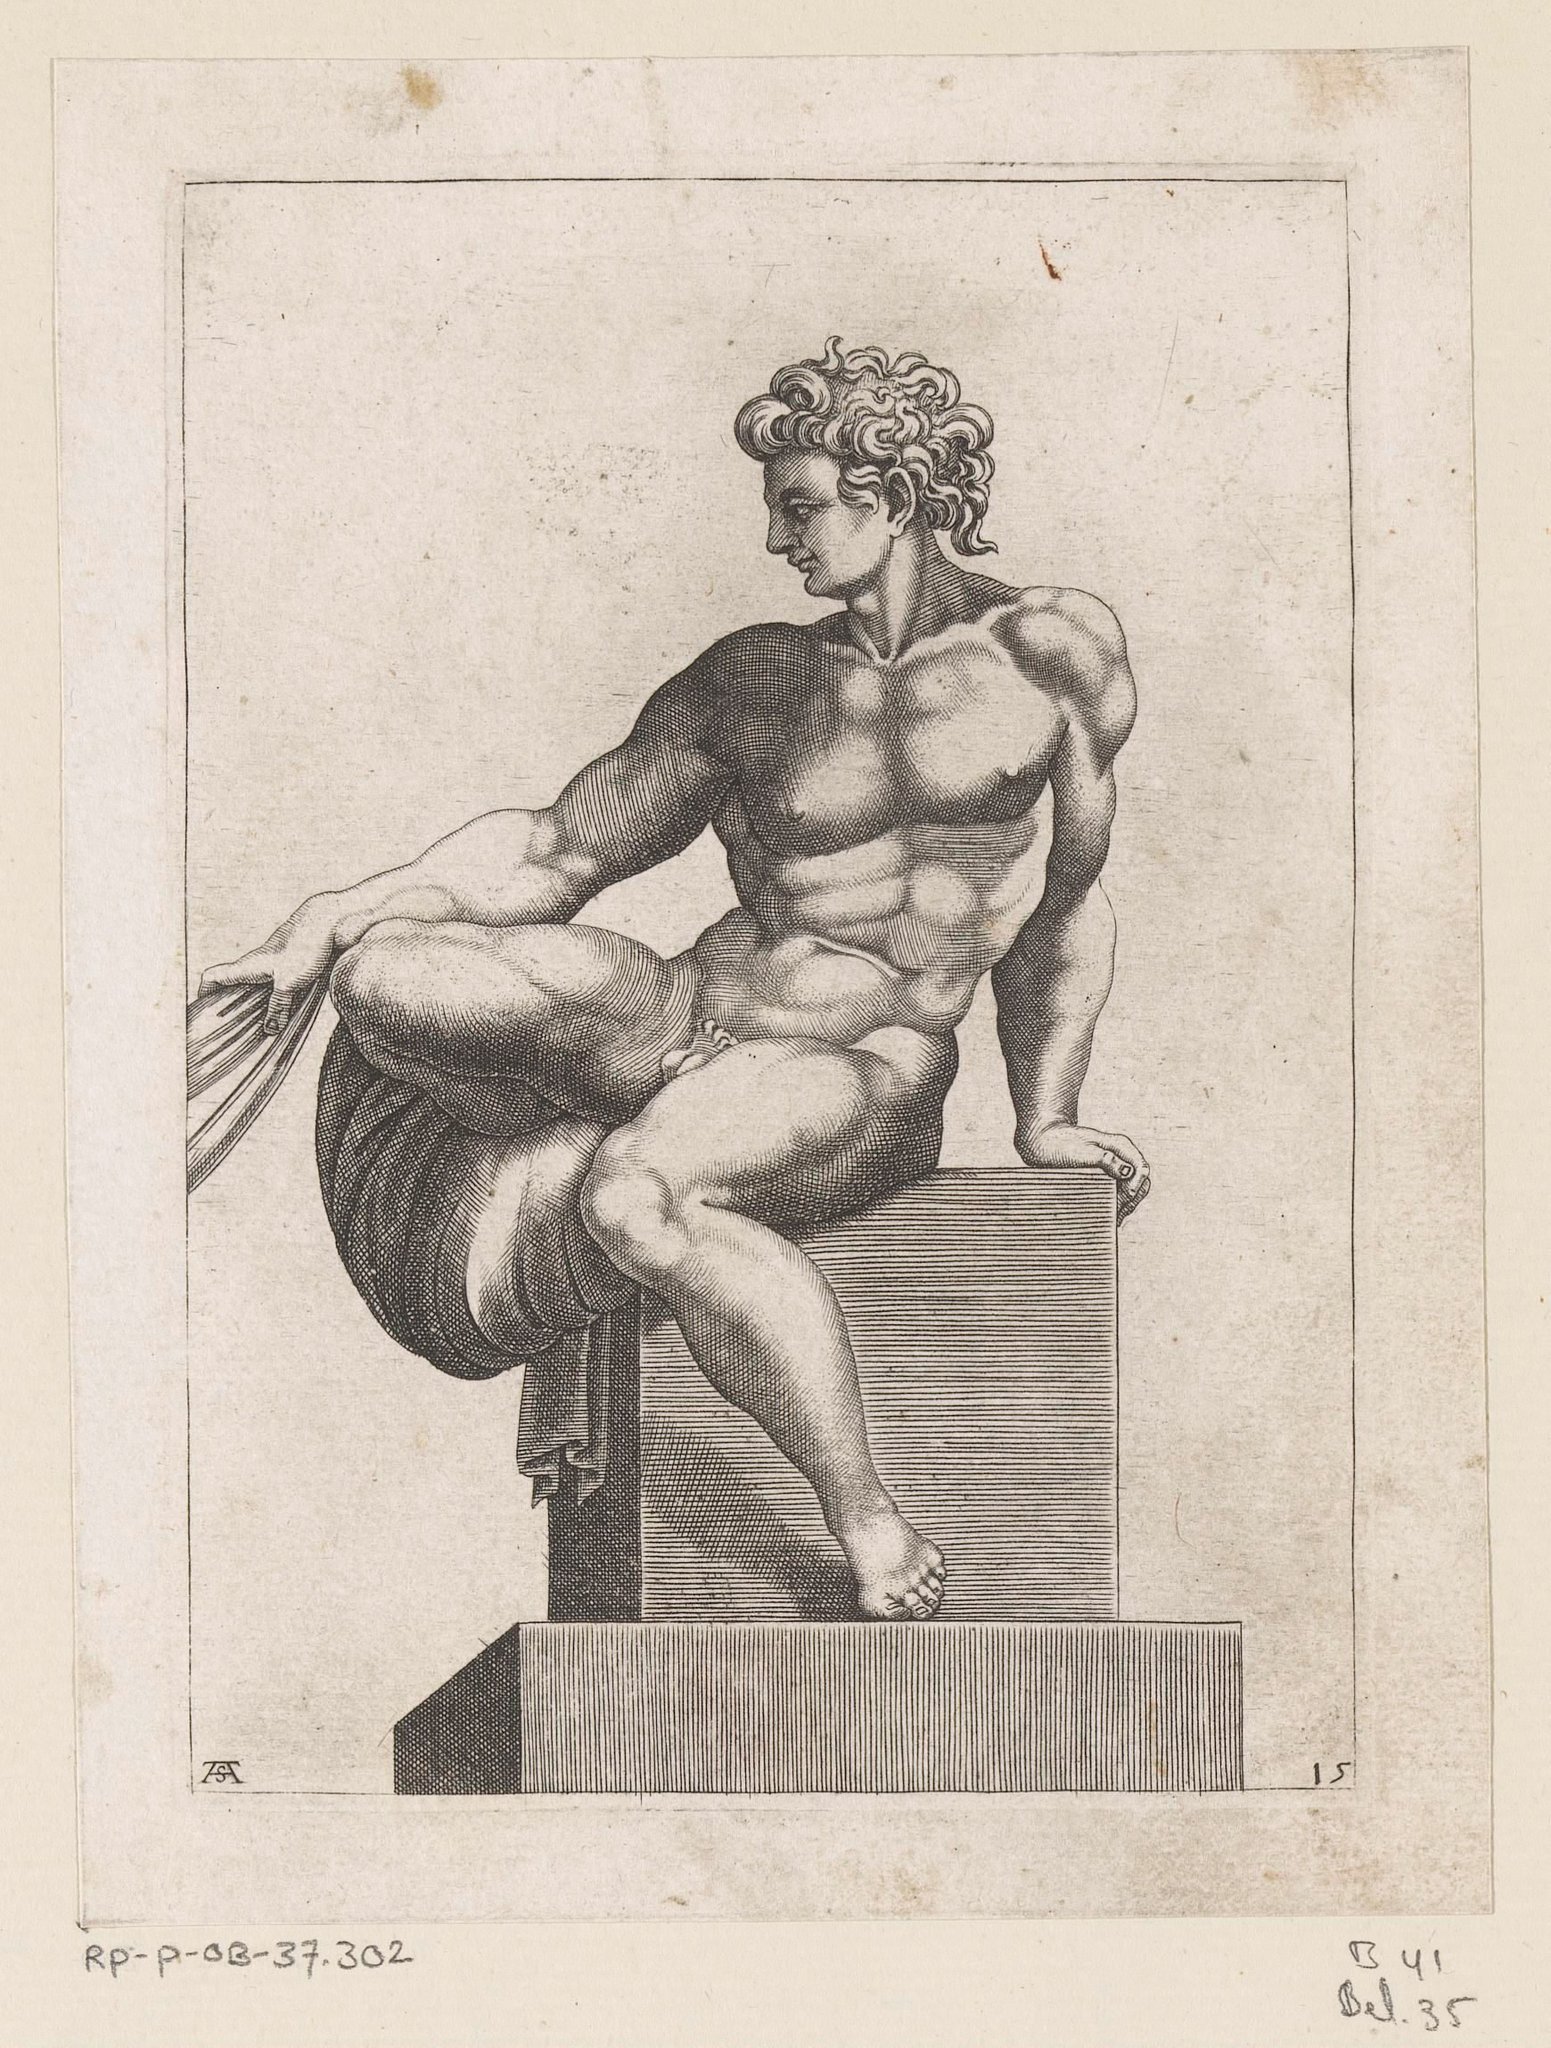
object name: print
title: Zittend naakt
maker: adamo scultori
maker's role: painter, print maker, sculptor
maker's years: 1530-1585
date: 1585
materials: paper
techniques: engraving, intaglio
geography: italy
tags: the (nude) human figure; 'corpo humano' (ripa)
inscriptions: collector's mark: Lugt 240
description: Deze prent maakt deel uit van een serie bestaande uit een titelprent en 72 prenten naar schilderingen door Michelangelo in de Sixtijnse Kapel in het Vaticaan.